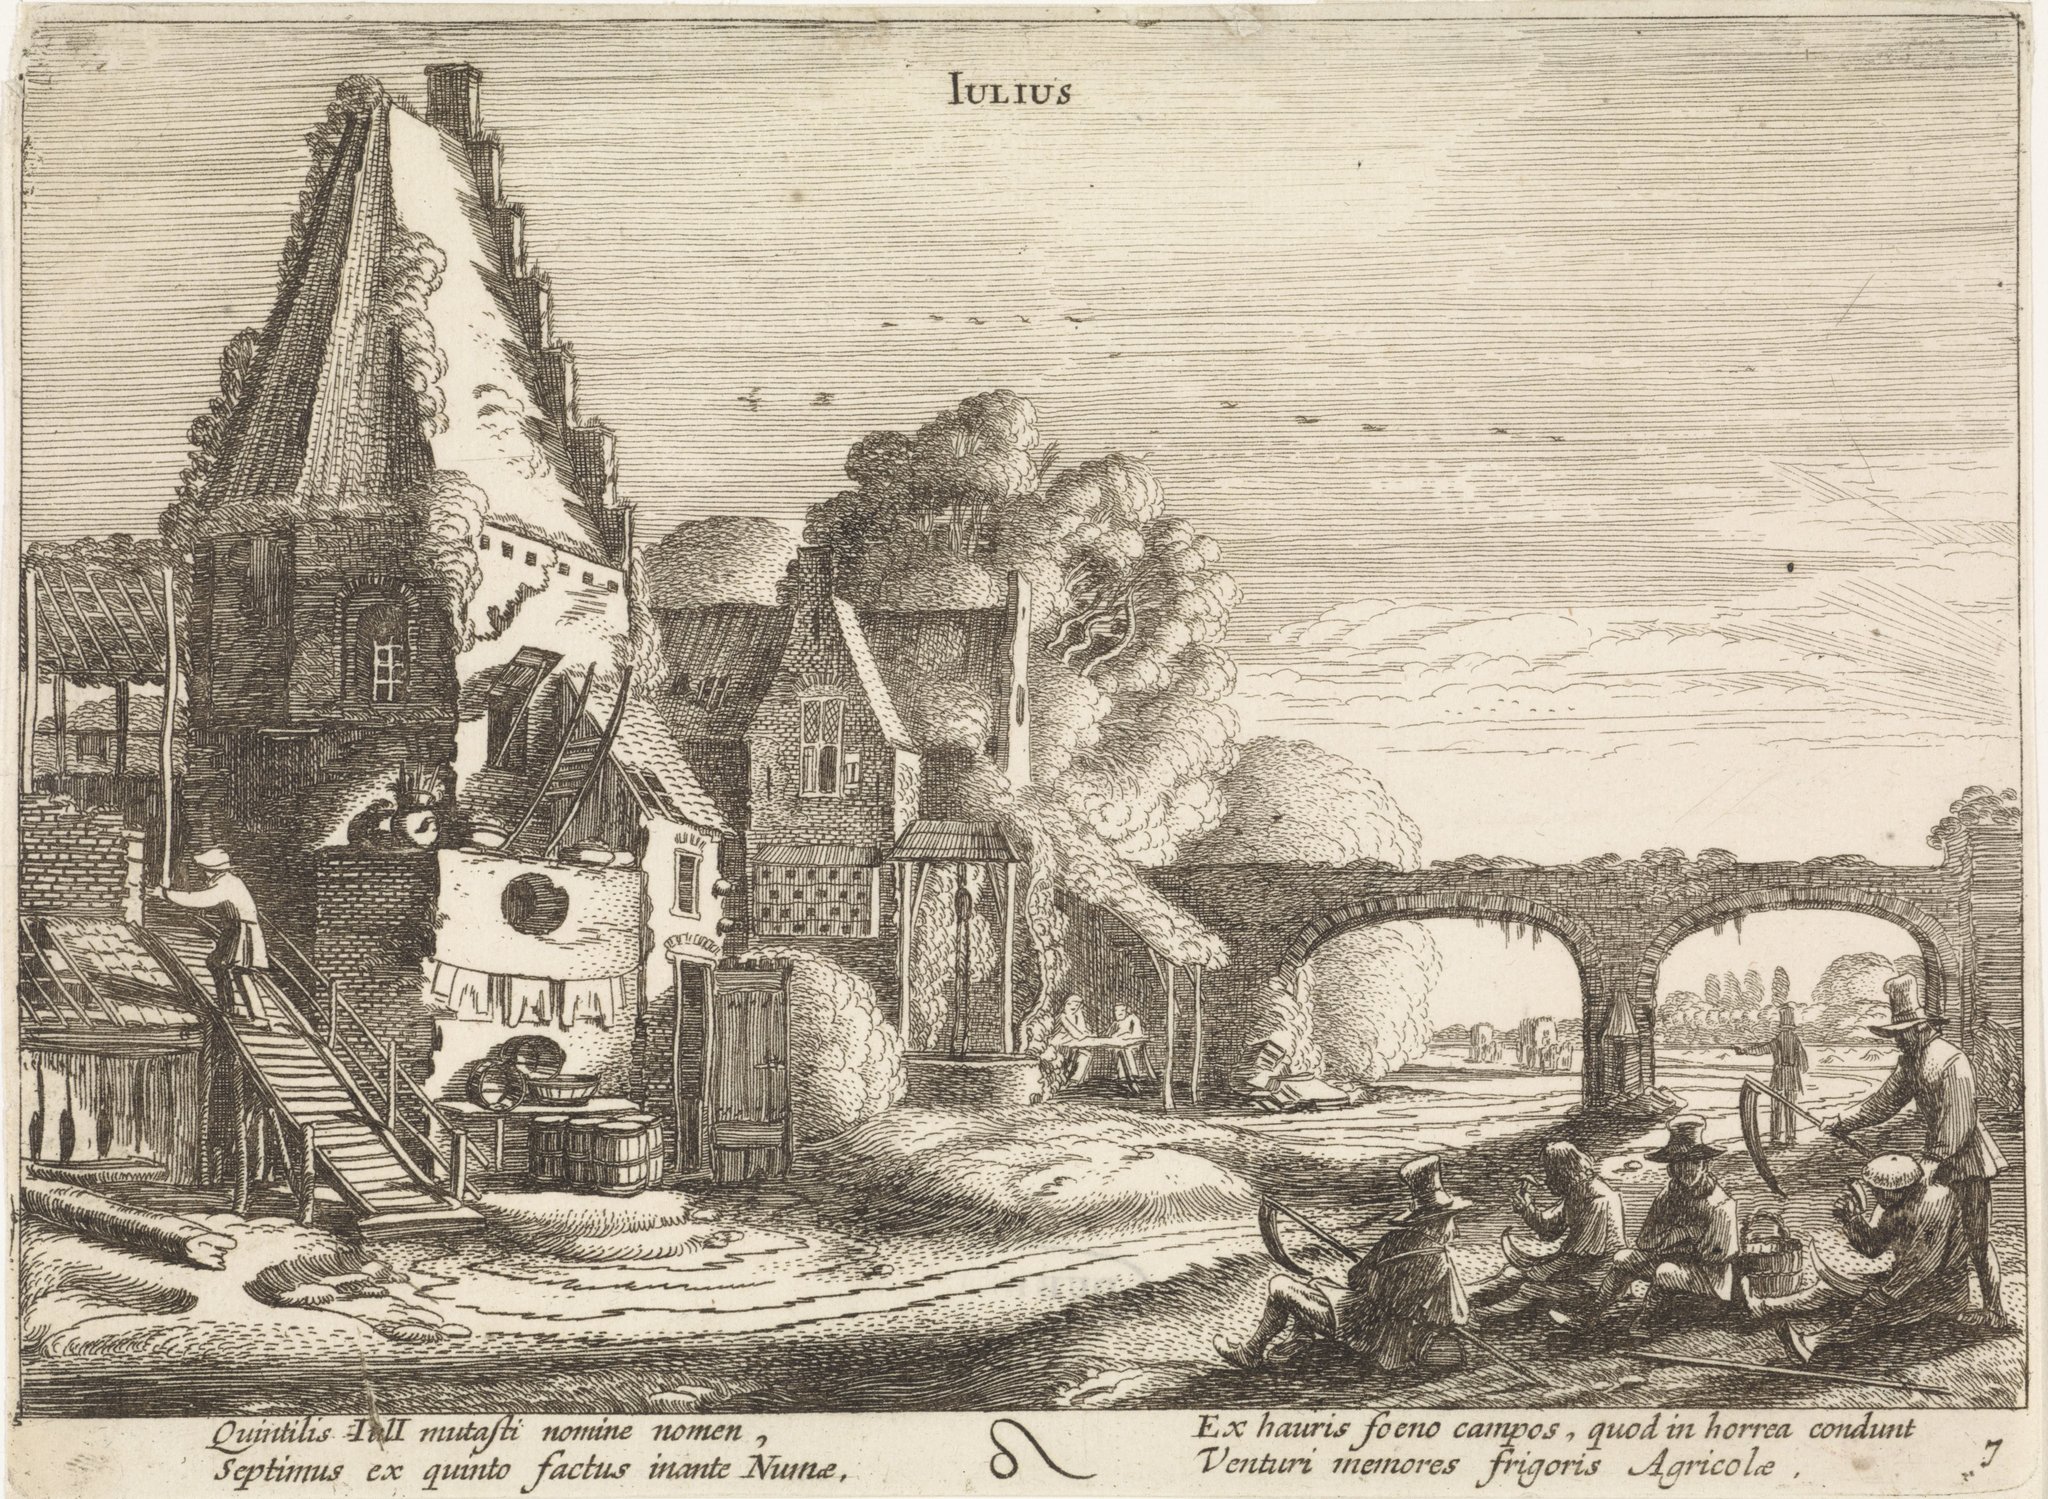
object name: print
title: De twaalf maanden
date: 1608-1618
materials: paper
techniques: etching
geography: northern netherlands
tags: agricultural implements: scythe, landscape with bridge, viaduct or aqueduct, leo (zodiacal sign of july), rest during harvest (eating, dancing, making love, etc.), tower (of house or building), landscape symbolizing july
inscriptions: collector's mark: Lugt 240, collector's mark: Lugt 698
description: Gezicht op een huis en een aqauduct, waarvoor rustende maaiers met hun zeisen, voorstellende de maand juli. In het midden twee figuren aan een tafel bij een waterput. Onderaan het astrologische symbool van het sterrenbeeld leeuw. Prent uit een serie van twaalf.